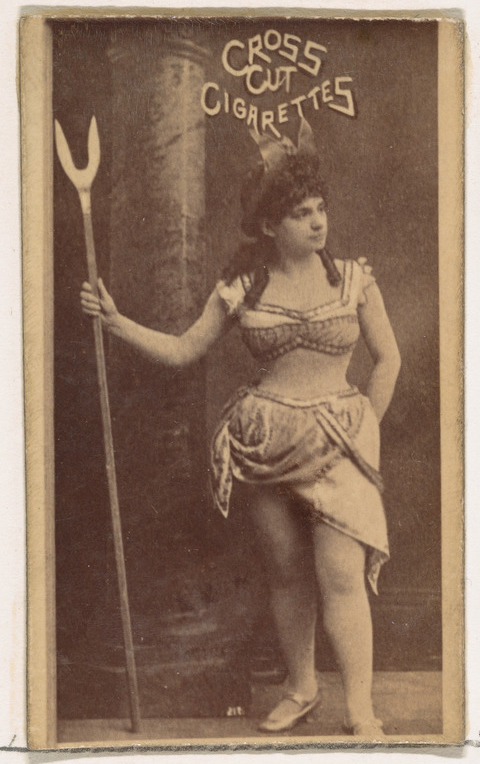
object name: print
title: Actress holding tall pointed staff, from the Actors and Actresses series (N145-1) issued by Duke Sons & Co. to promote Cross Cut Cigarettes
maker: w. duke, sons & co.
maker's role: publisher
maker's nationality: american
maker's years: 1870-1920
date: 1880-1889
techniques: albumen silver print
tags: portraits,women,actresses